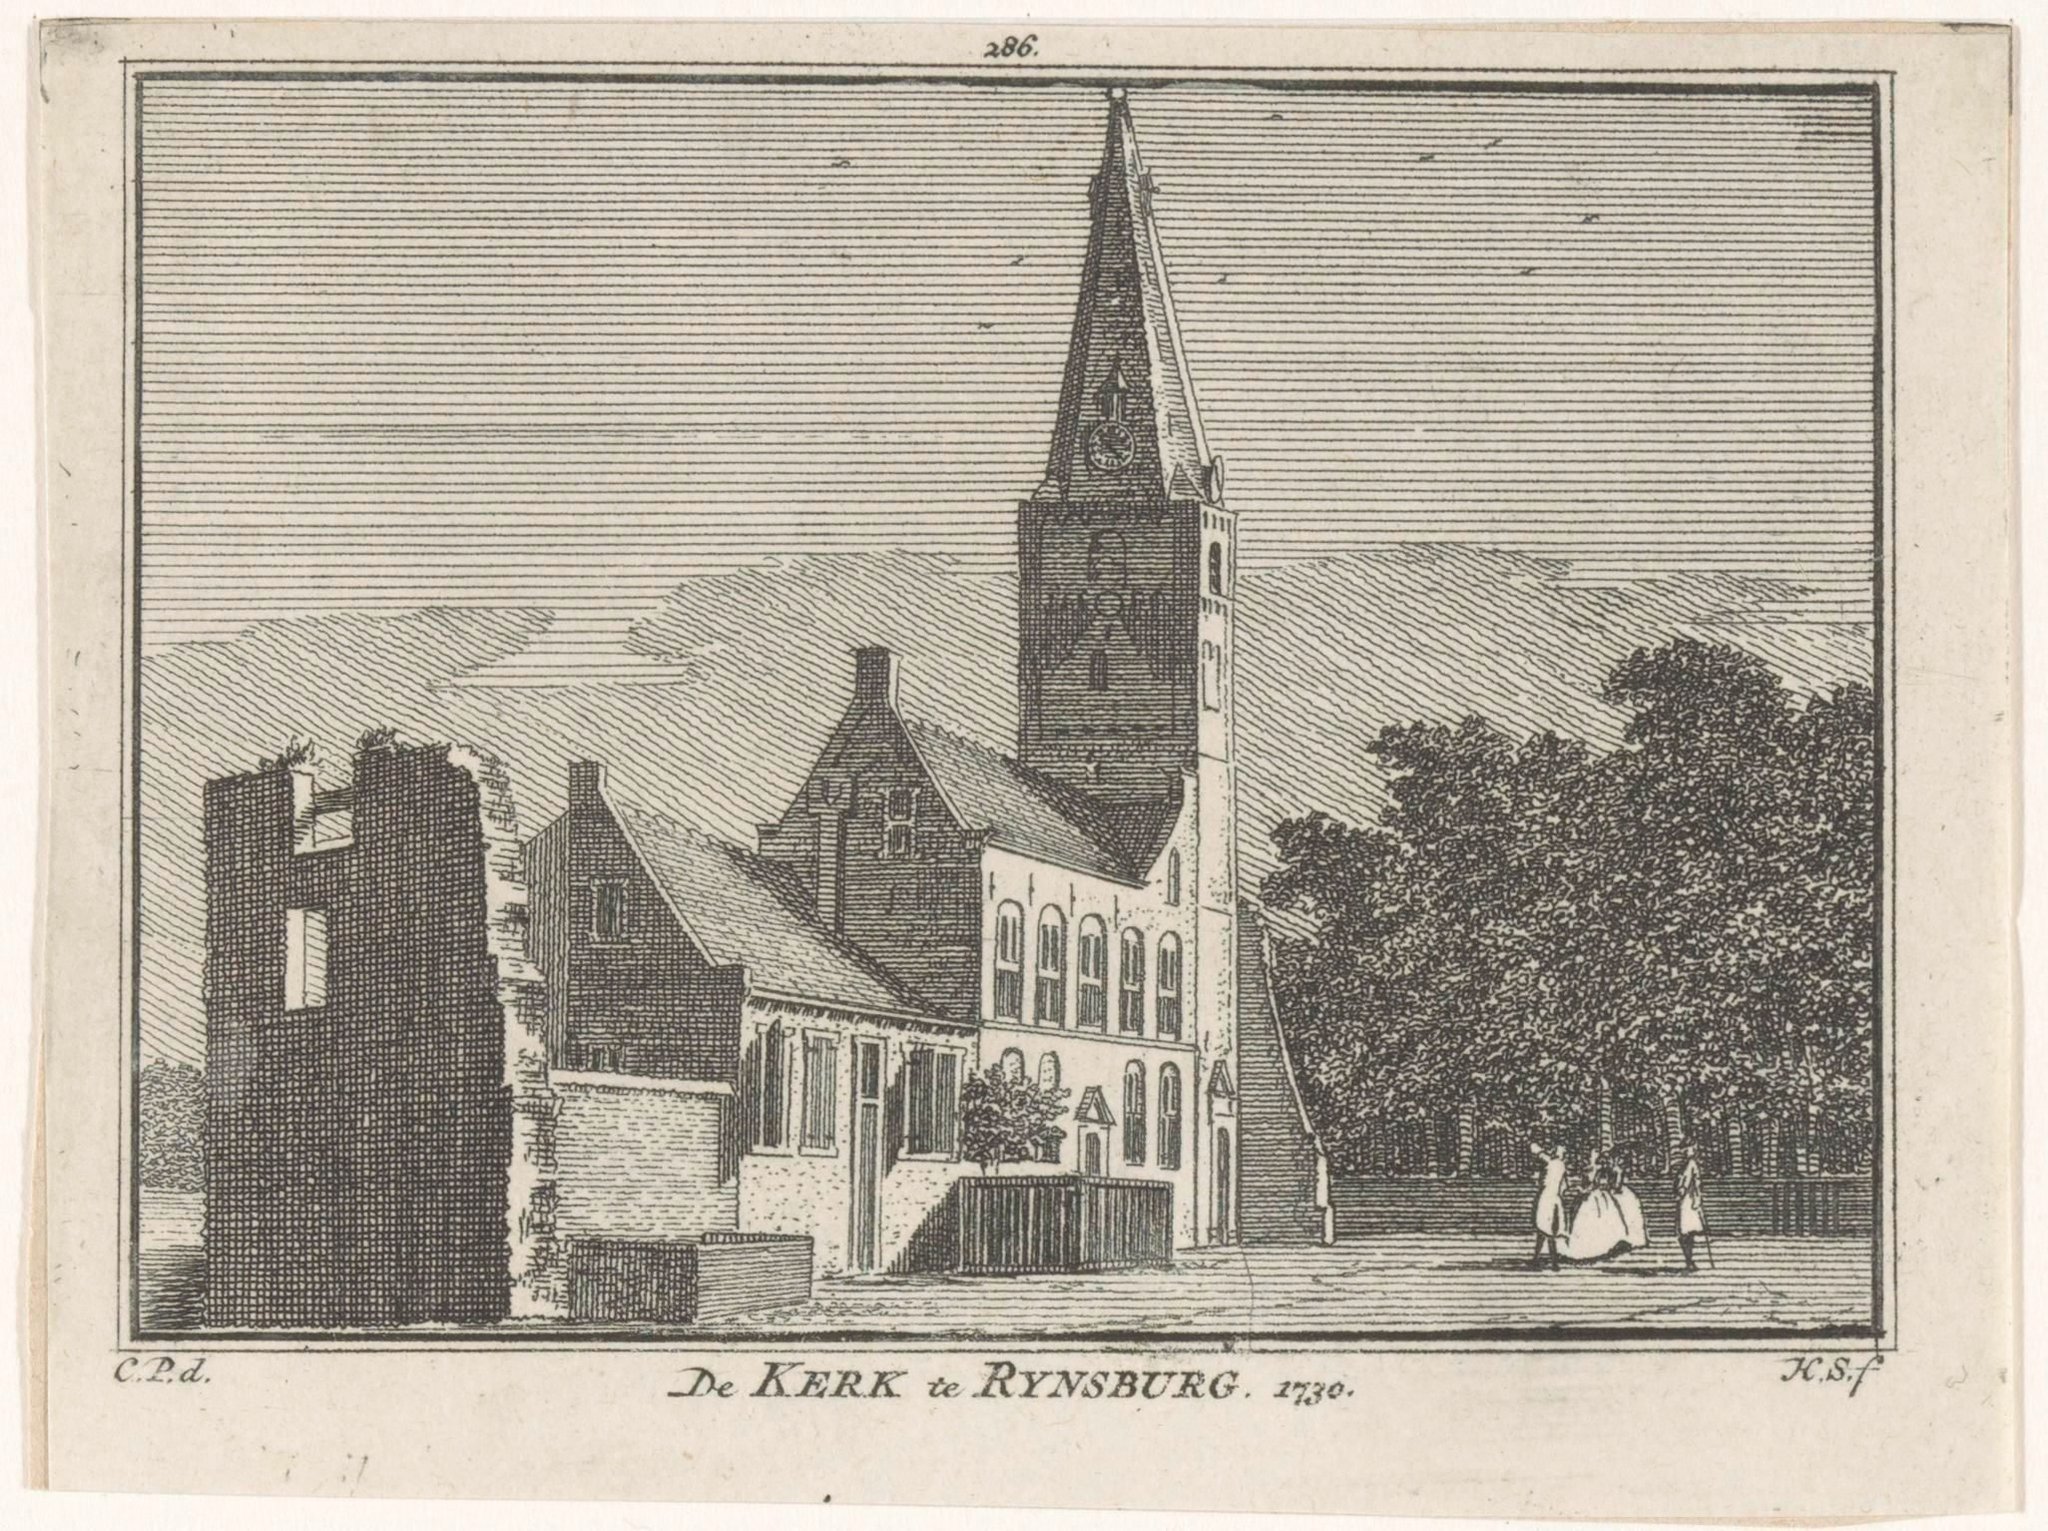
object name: print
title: De kerk te Rynsburg. 1730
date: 1750-1792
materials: paper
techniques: engraving, etching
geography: haarlem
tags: church (exterior)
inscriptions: collector's mark: Lugt 2228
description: Prent ook gebruikt in: Het verheerlykt Nederland of kabinet van hedendaagsche gezigten van steden, dorpen (…). 9 delen. Amsterdam: Isaak Tirion en weduwe Isaak Tirion, 1745-1774, dl. 3 (1750), ill. 286. Of in: Nederlandsche tafereelen; of eene keurige verzameling van negen honderd fraaije gezigten van steden, dorpen, sloten, oudheden (….). 9 delen. Amsterdam: Jan de Groot, 1792, dl. 3, ill. 286.